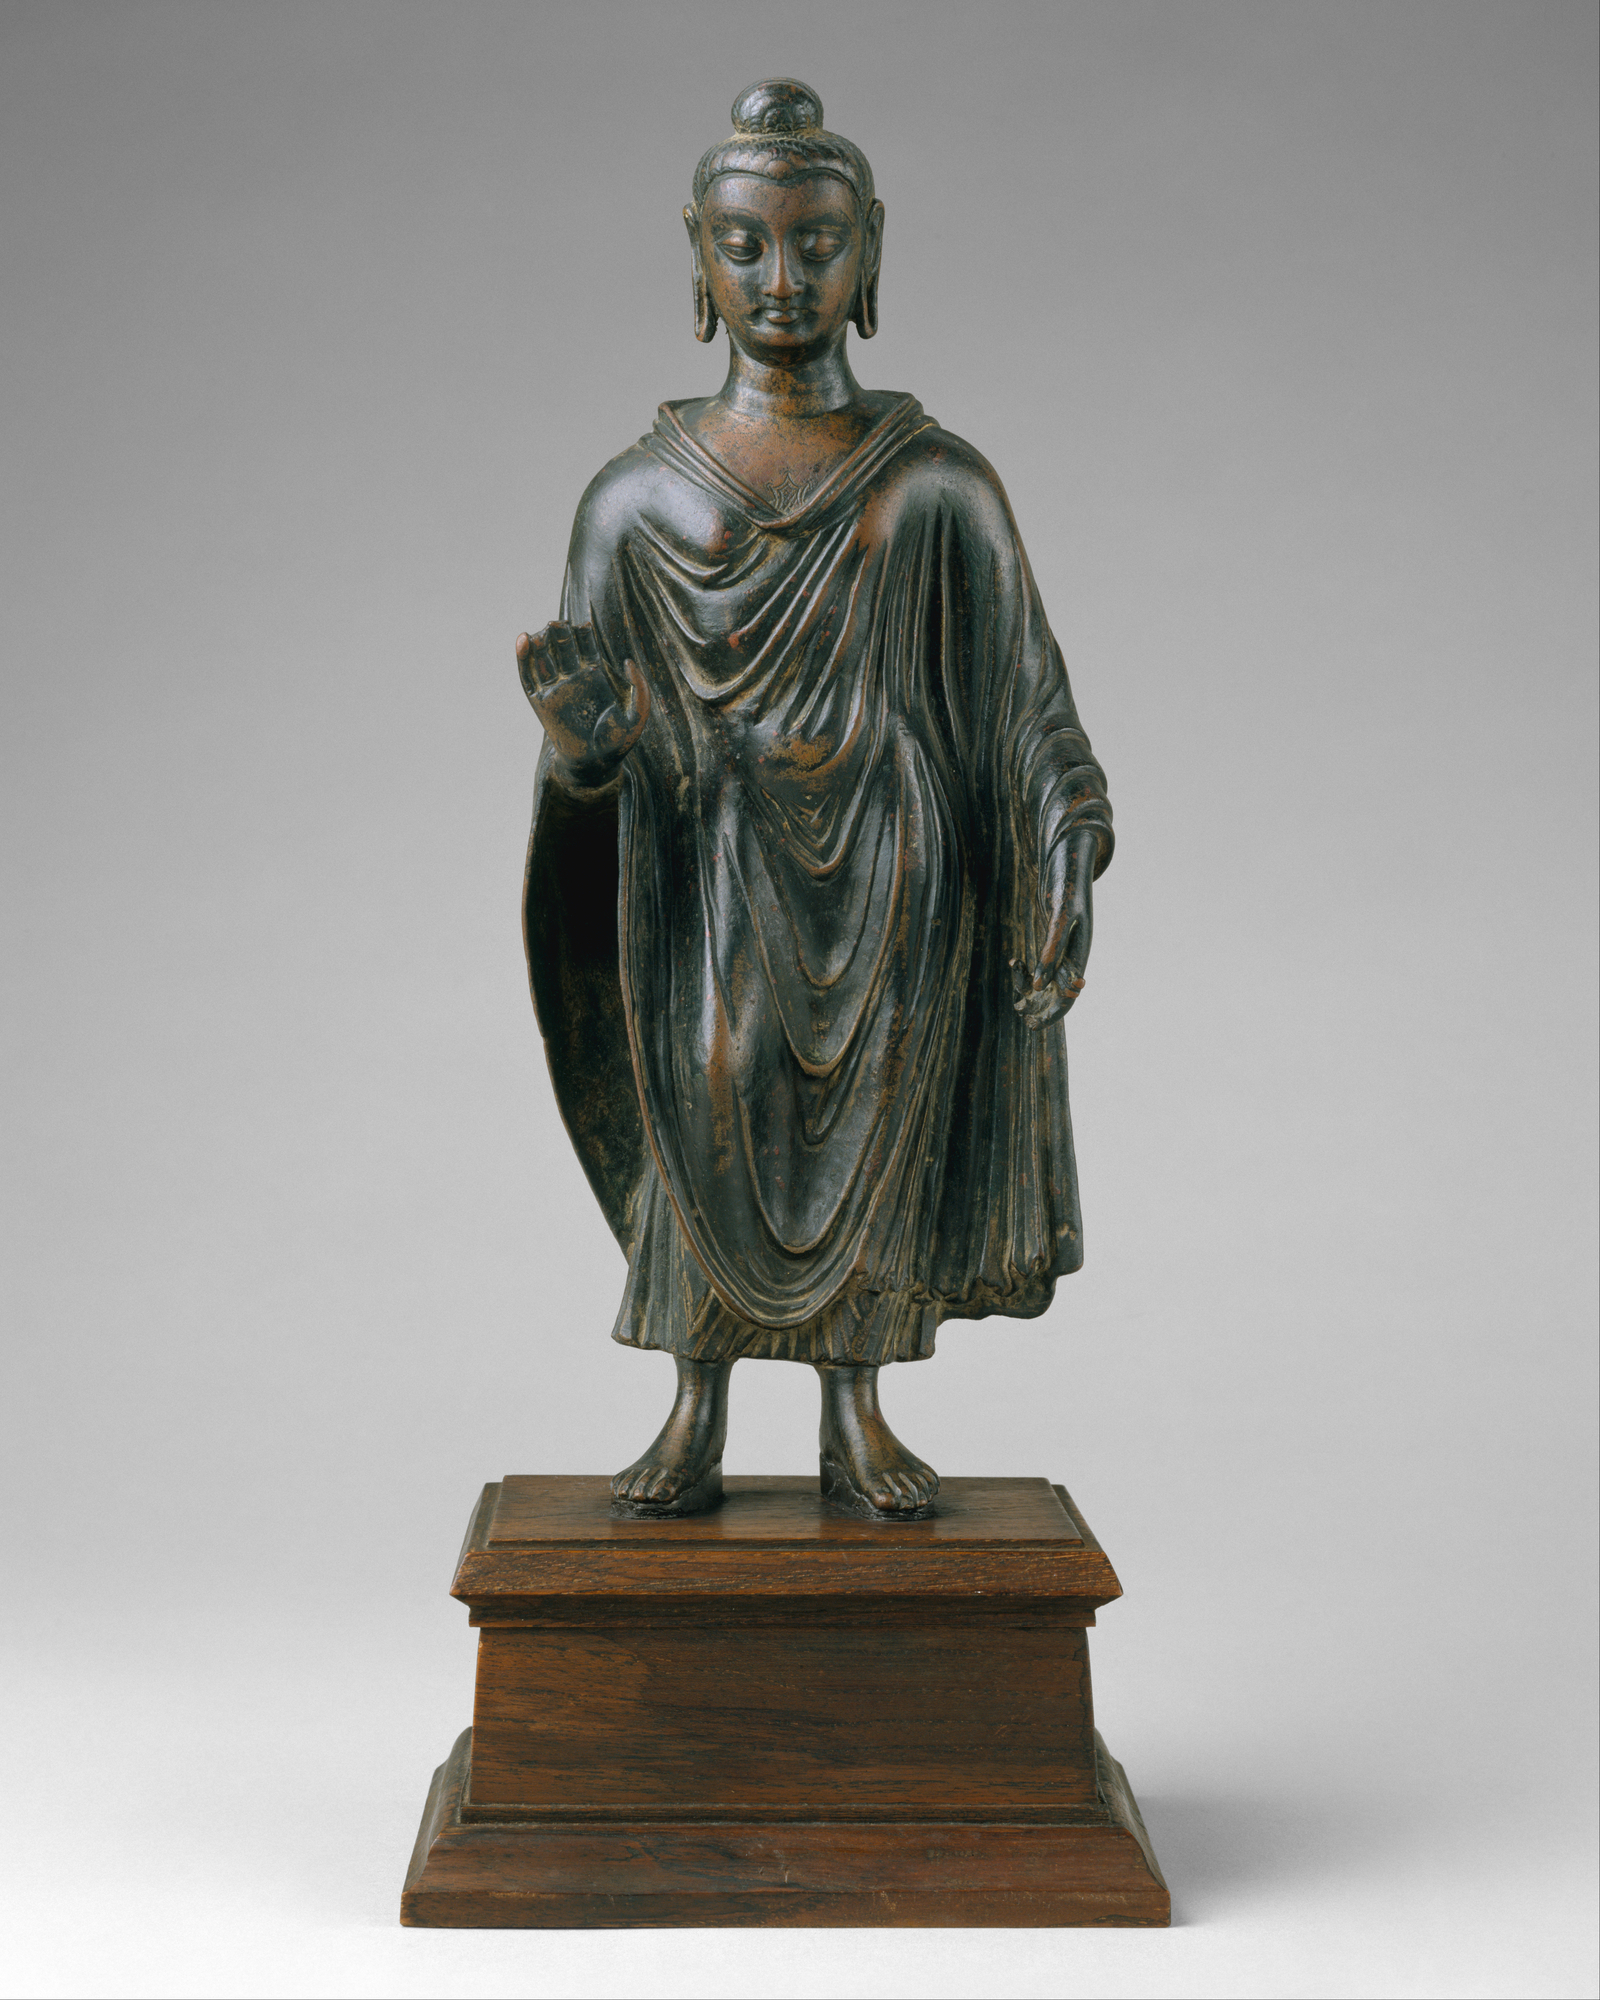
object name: figure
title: Standing Buddha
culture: afghanistan or gandhara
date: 567-600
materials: brass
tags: gandhara,buddhism,buddha